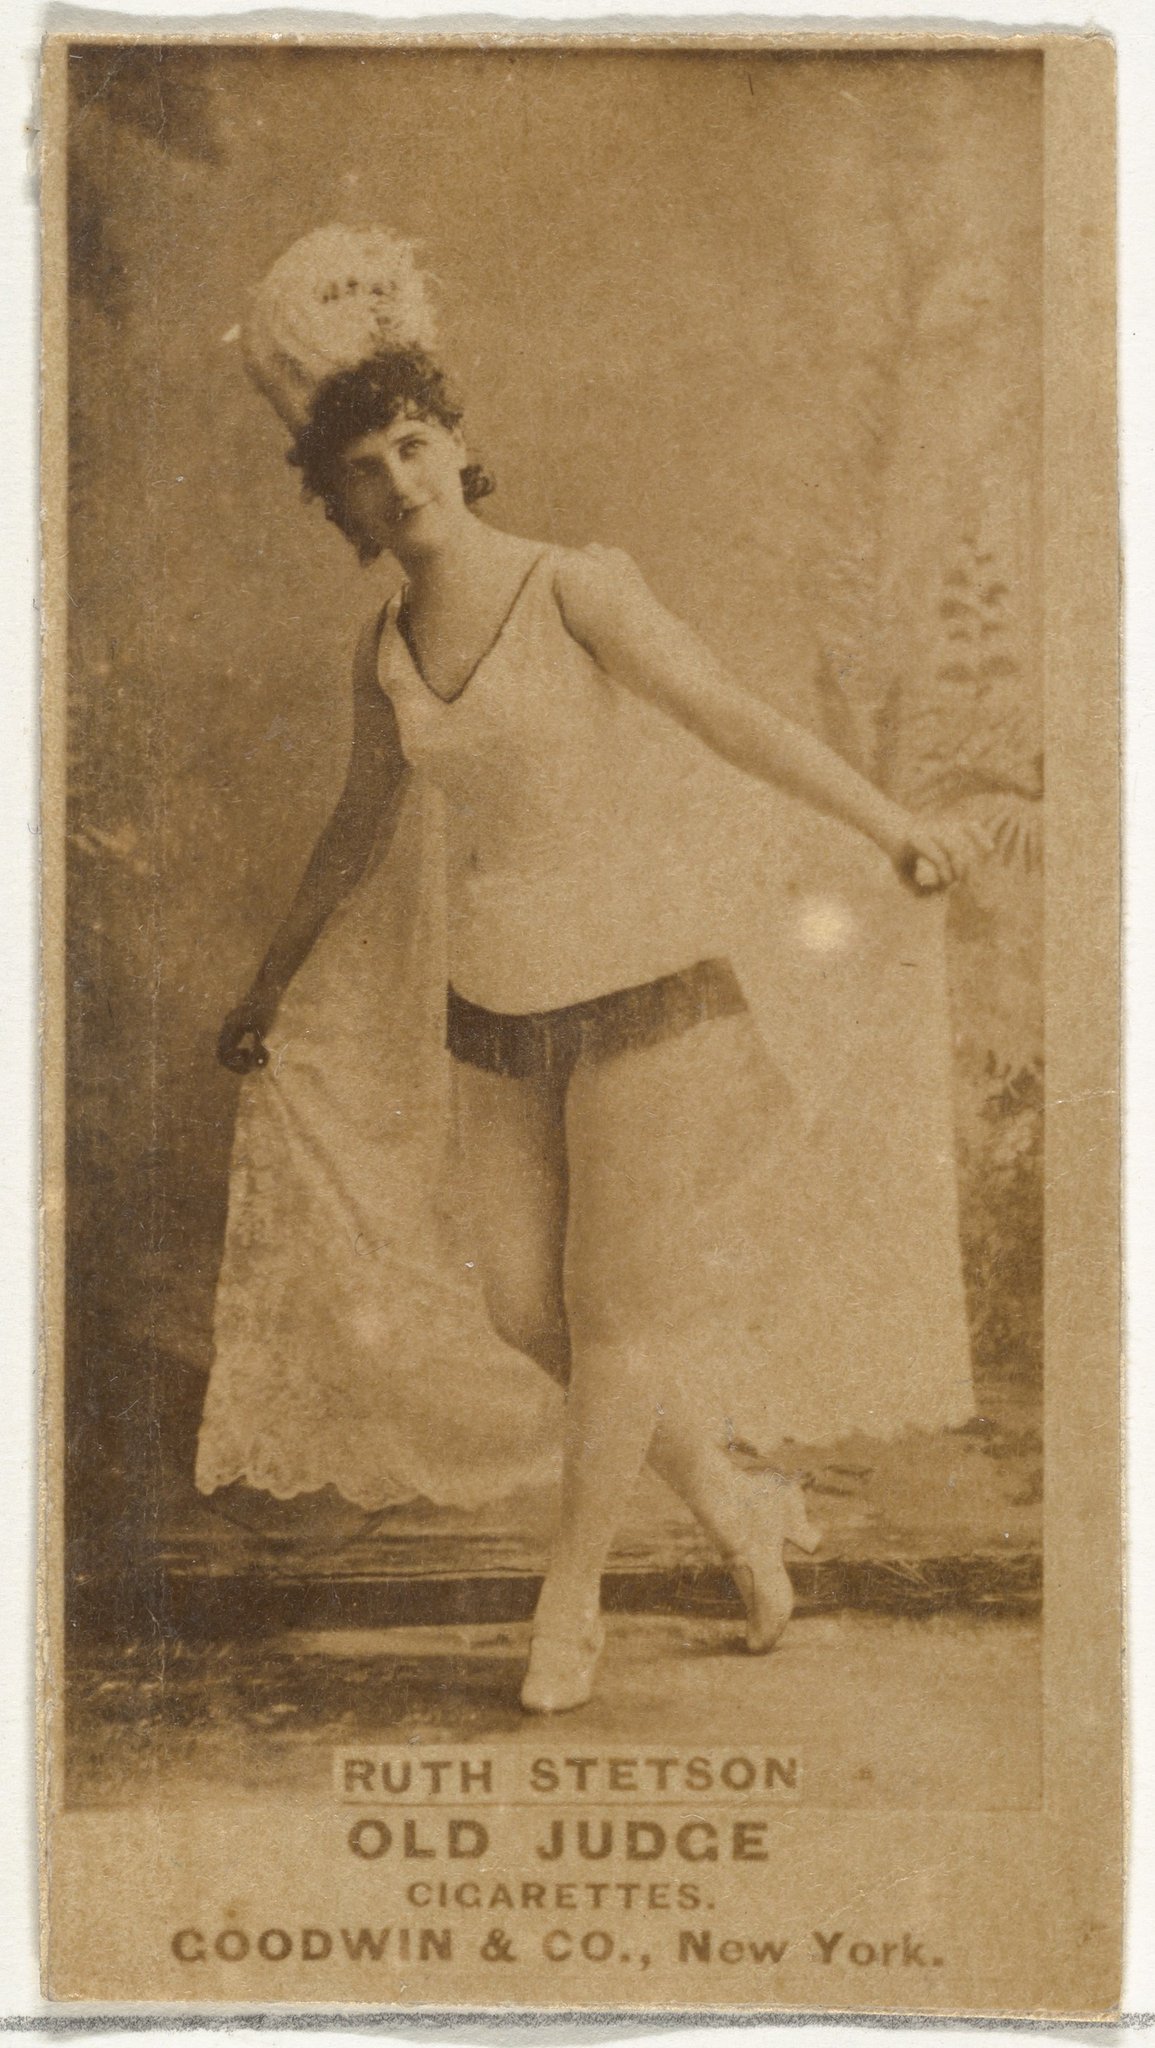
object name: photograph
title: Ruth Stetson, from the Actors and Actresses series (N171) for Old Judge Cigarettes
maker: goodwin & company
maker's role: publisher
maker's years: 1850-1950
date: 1886-1890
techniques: albumen silver print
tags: portraits,women,actresses